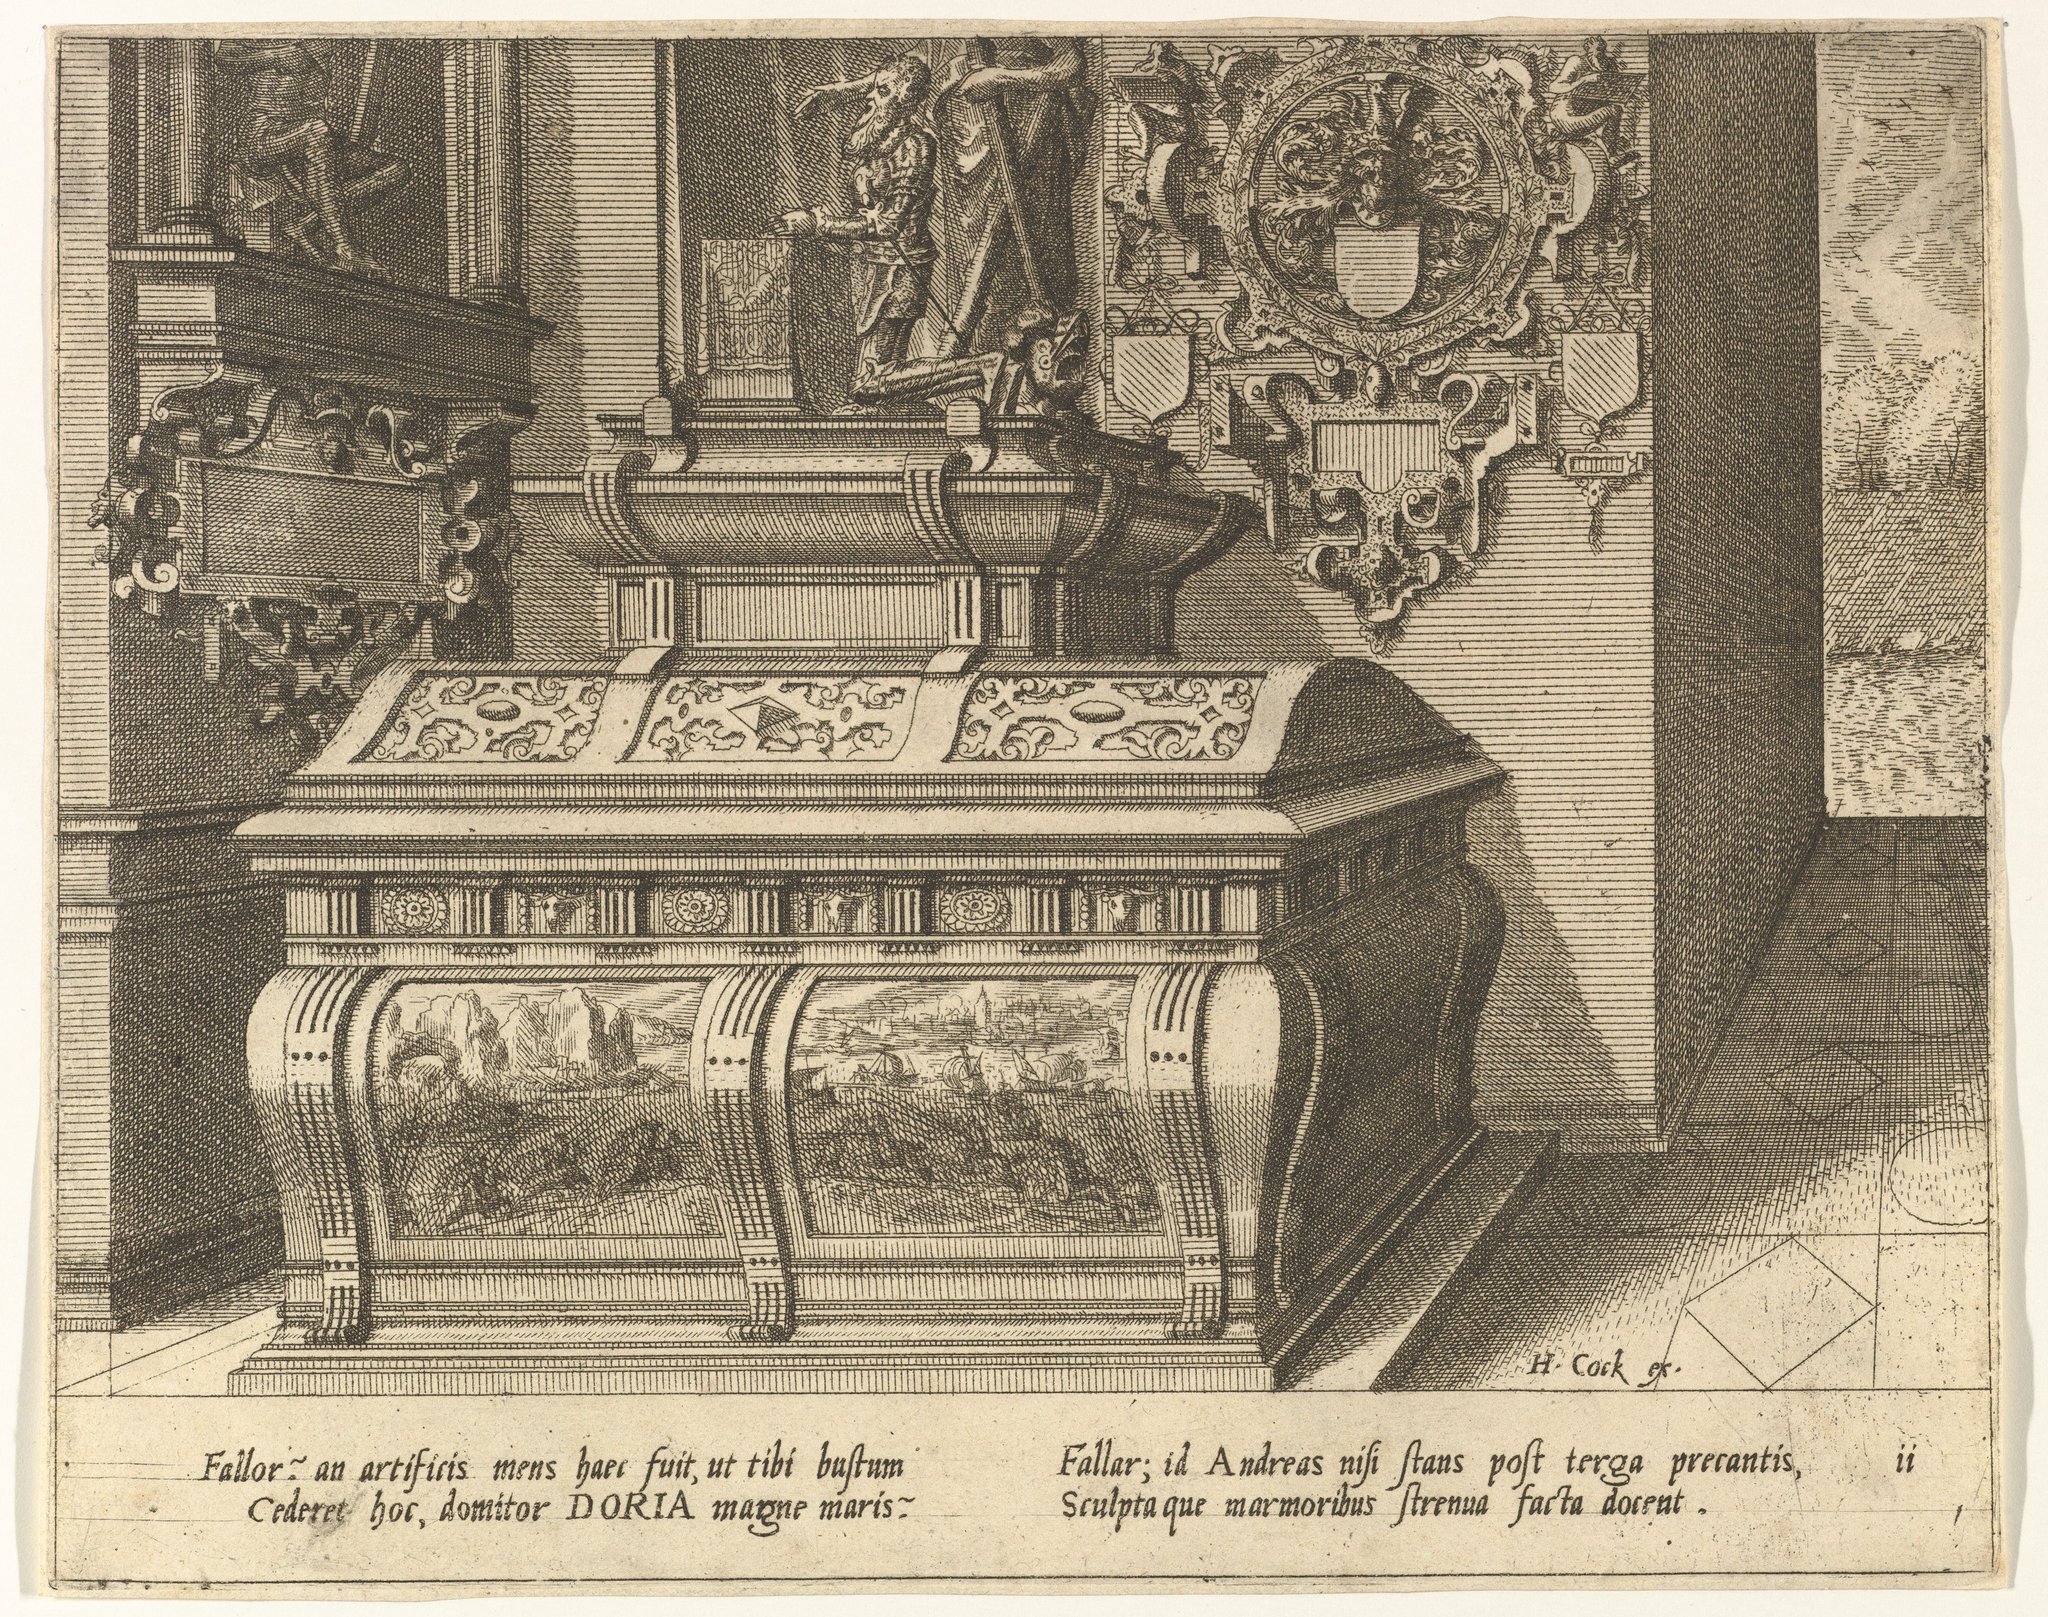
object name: collection ornament architecture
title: Cœnotaphiorum (11)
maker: hans vredeman de vries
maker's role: artist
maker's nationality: netherlandish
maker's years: 1527-1606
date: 1563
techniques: etching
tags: tombs,battles,men,saints